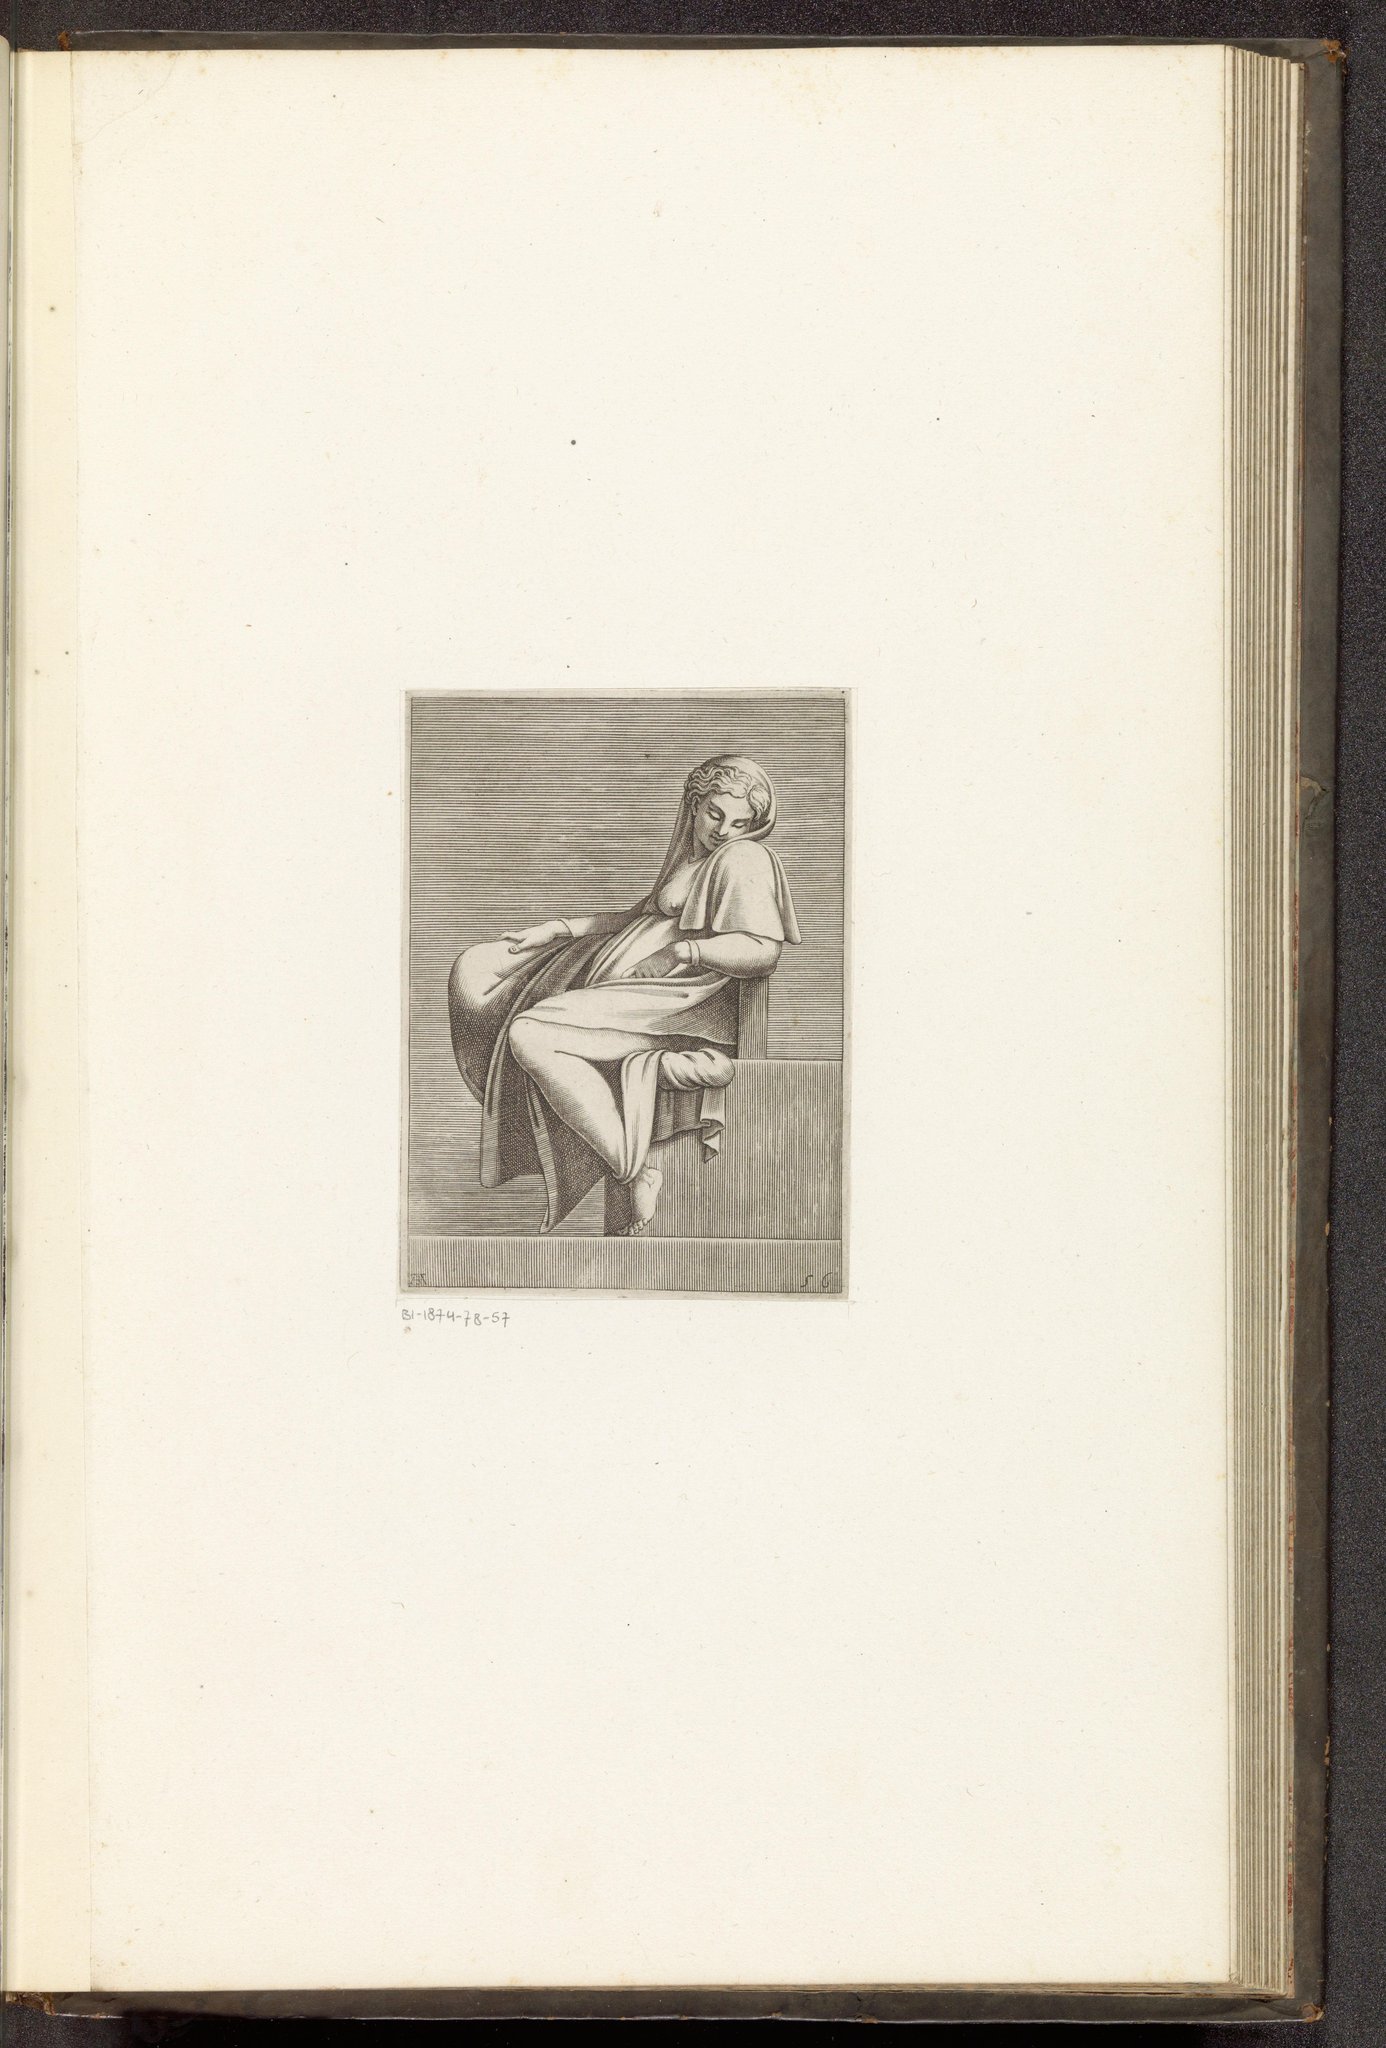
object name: album leaf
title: Zittende jonge vrouw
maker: adamo scultori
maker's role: painter, print maker, sculptor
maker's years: 1530-1585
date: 1585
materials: paper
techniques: engraving, intaglio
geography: italy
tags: adolescent, young woman, maiden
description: Deze prent maakt deel uit van een serie bestaande uit een titelprent en 72 prenten naar schilderingen door Michelangelo in de Sixtijnse Kapel in het Vaticaan.